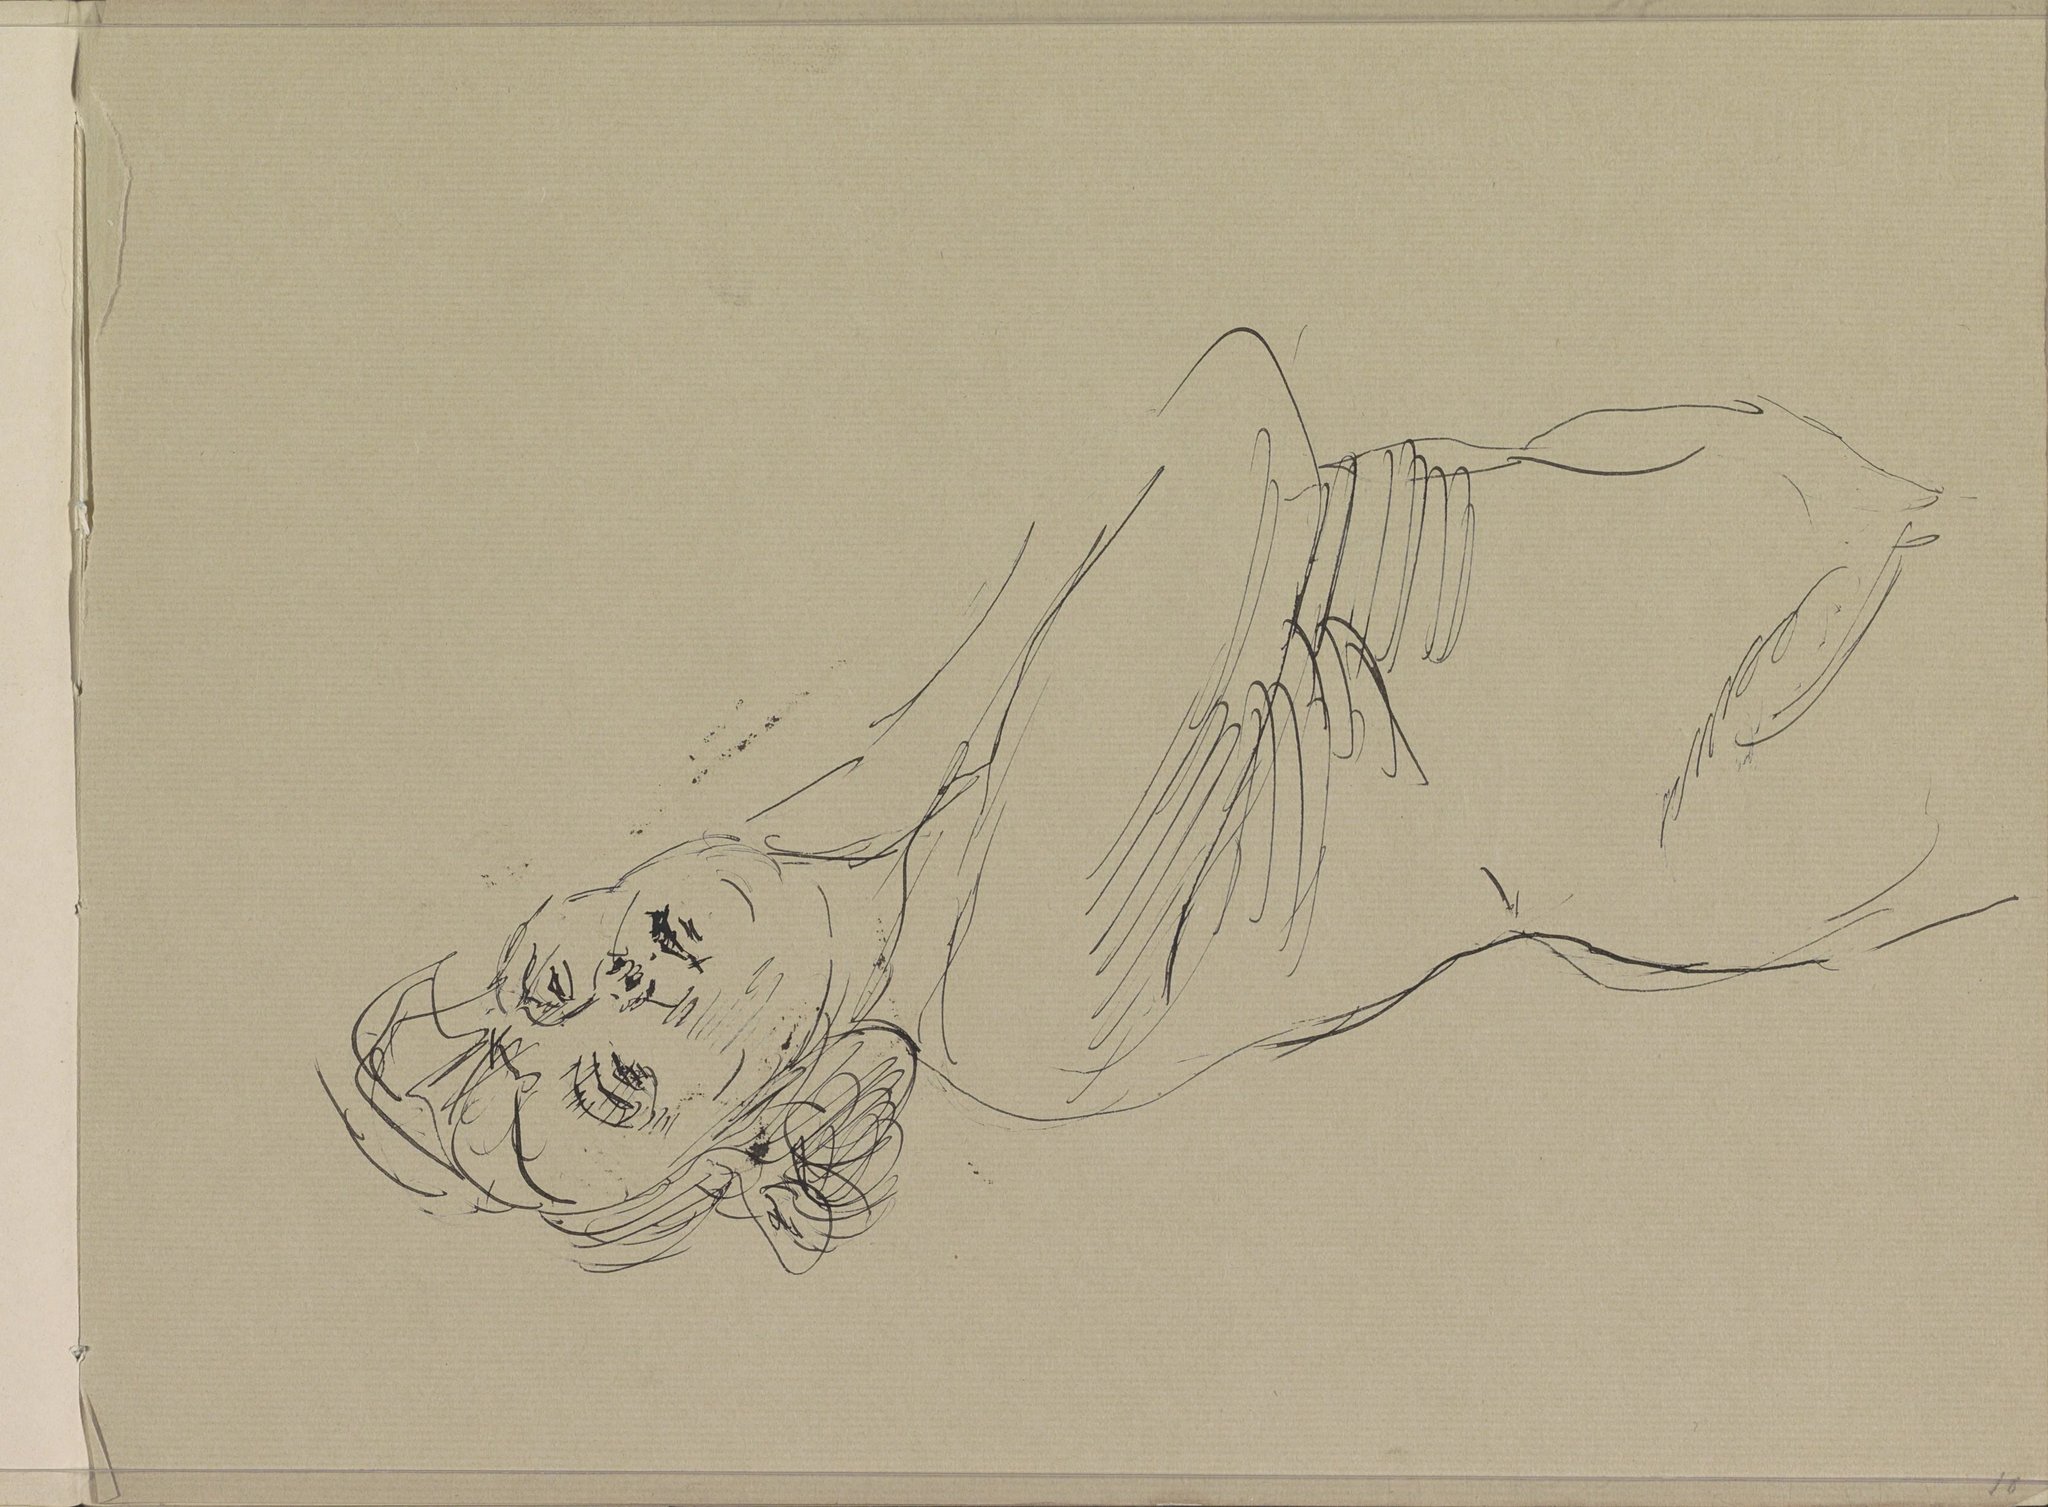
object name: sketchbook leaf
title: Vrouwelijk naakt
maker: isaac israels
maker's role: draughtsman, painter, print maker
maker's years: 1865-1934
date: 1875-1934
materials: ink, paper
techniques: pen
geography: the hague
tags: the (nude) human figure; 'corpo humano' (ripa) - aa - female human figure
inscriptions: watermark: ‘Holland’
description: Ze houdt haar hand bij haar gezicht. Blad 10 recto uit schetsboek IV met 27 bladen.